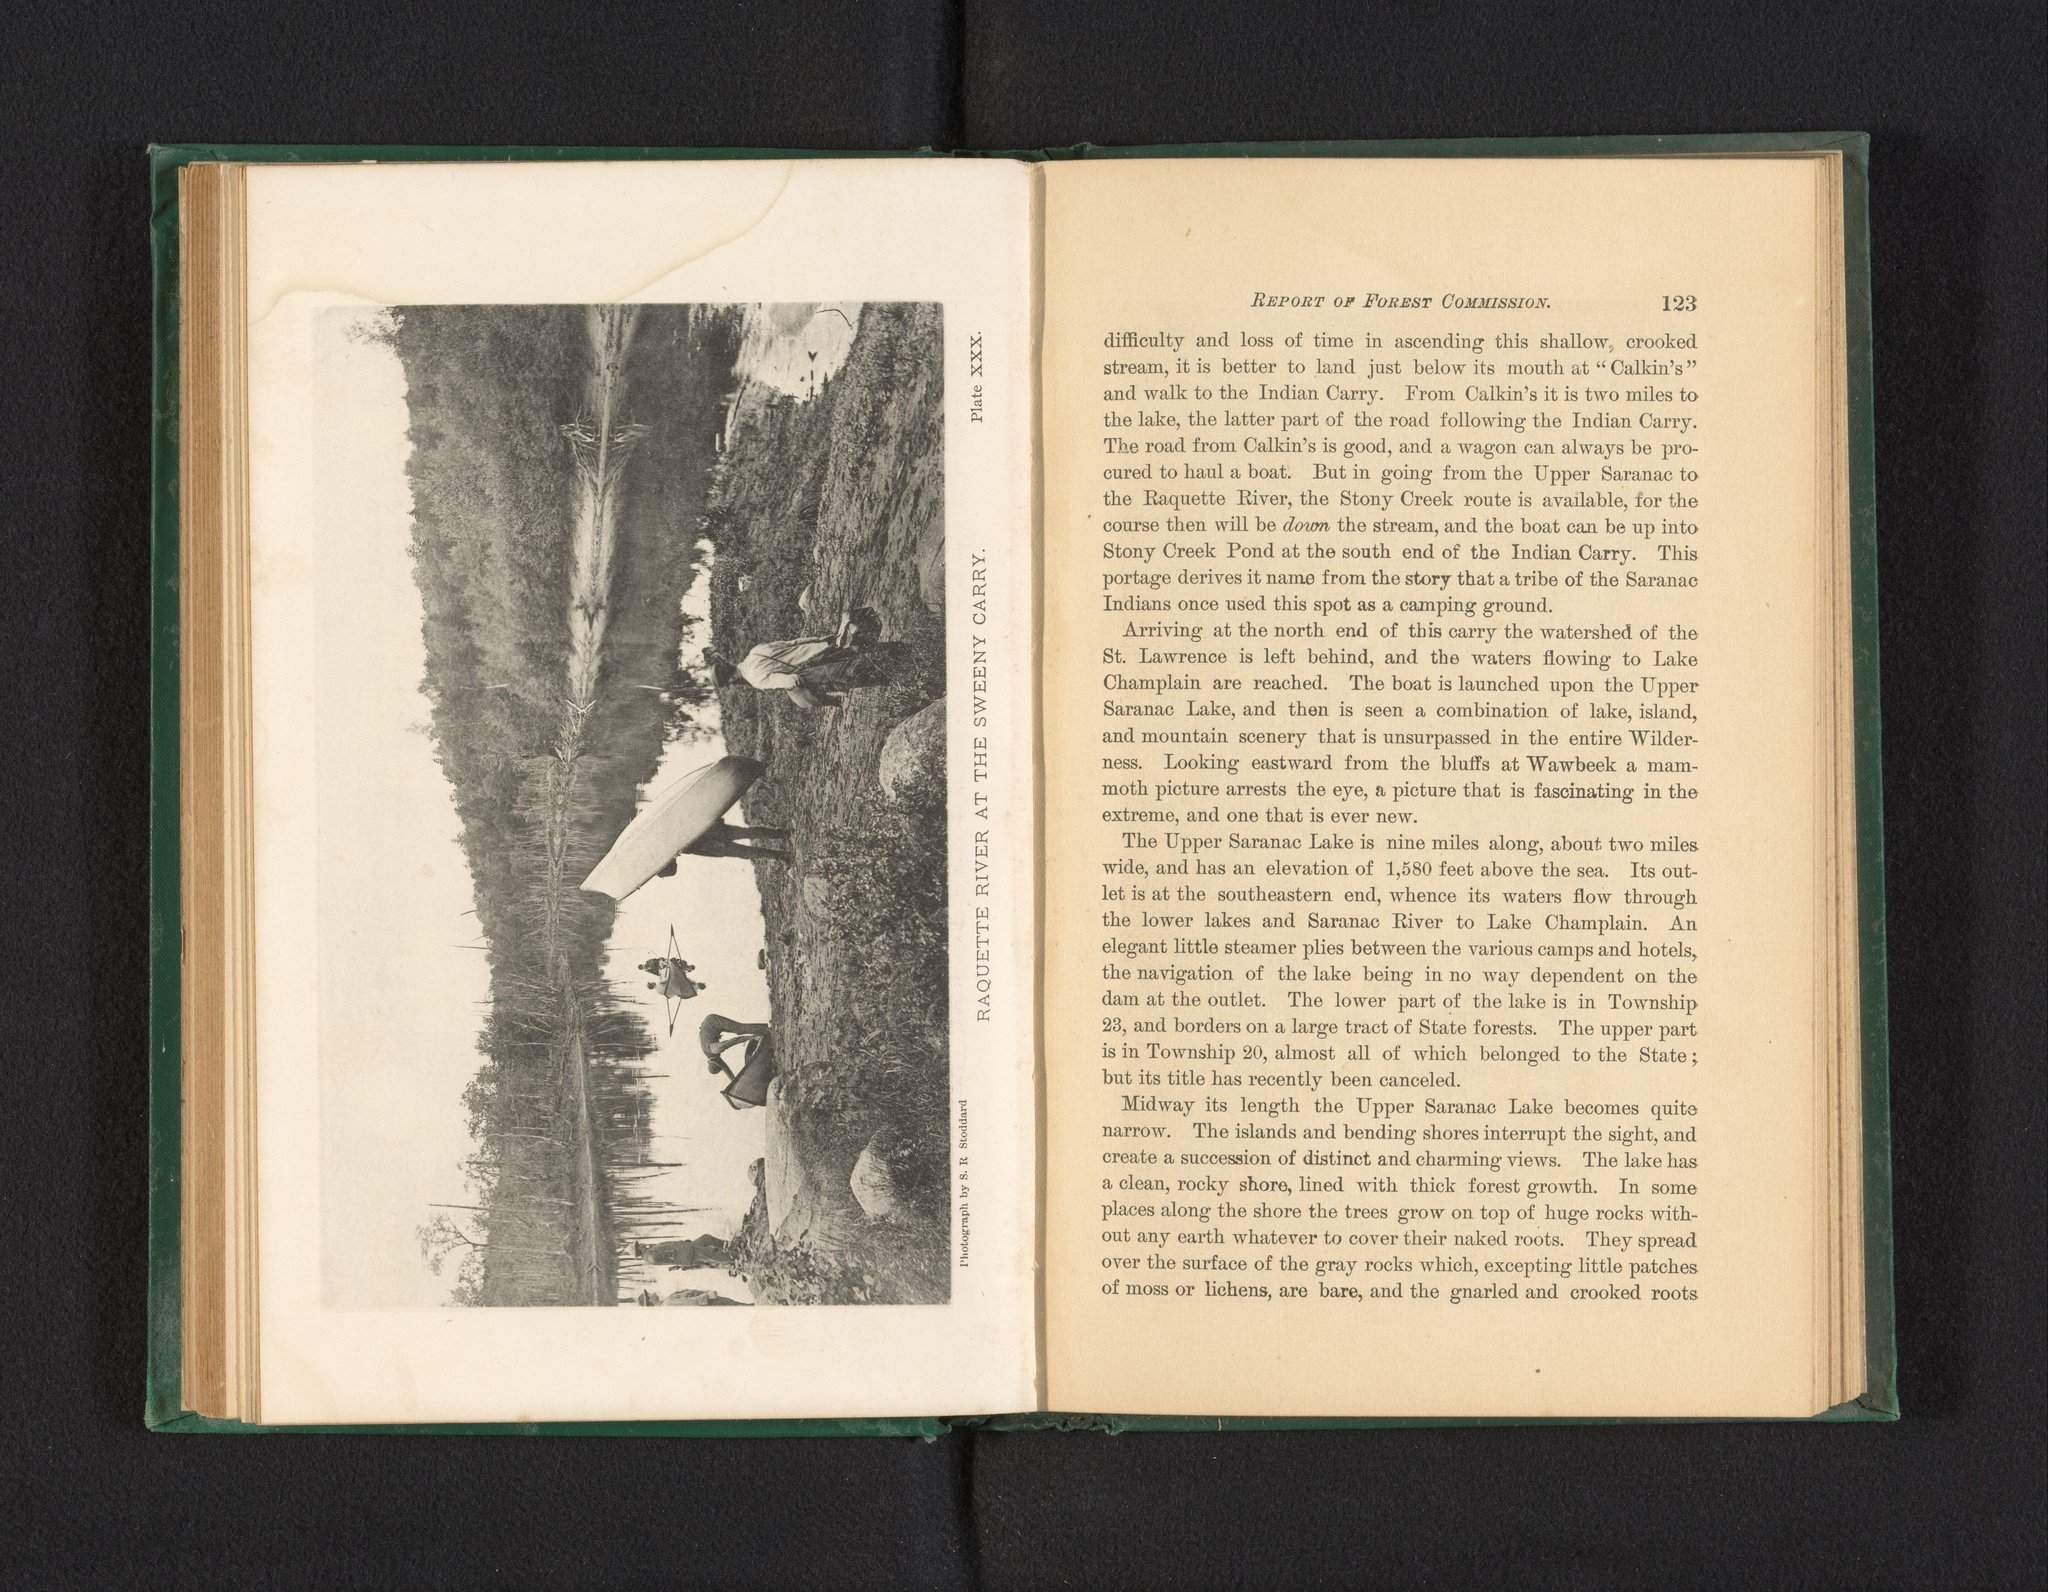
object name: photomechanical print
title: Raquette River at the Sweeny Carry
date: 1891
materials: paper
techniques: photograph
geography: new york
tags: river, rowing-boat, canoe, etc.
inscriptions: number: ‘Plate XXX.’